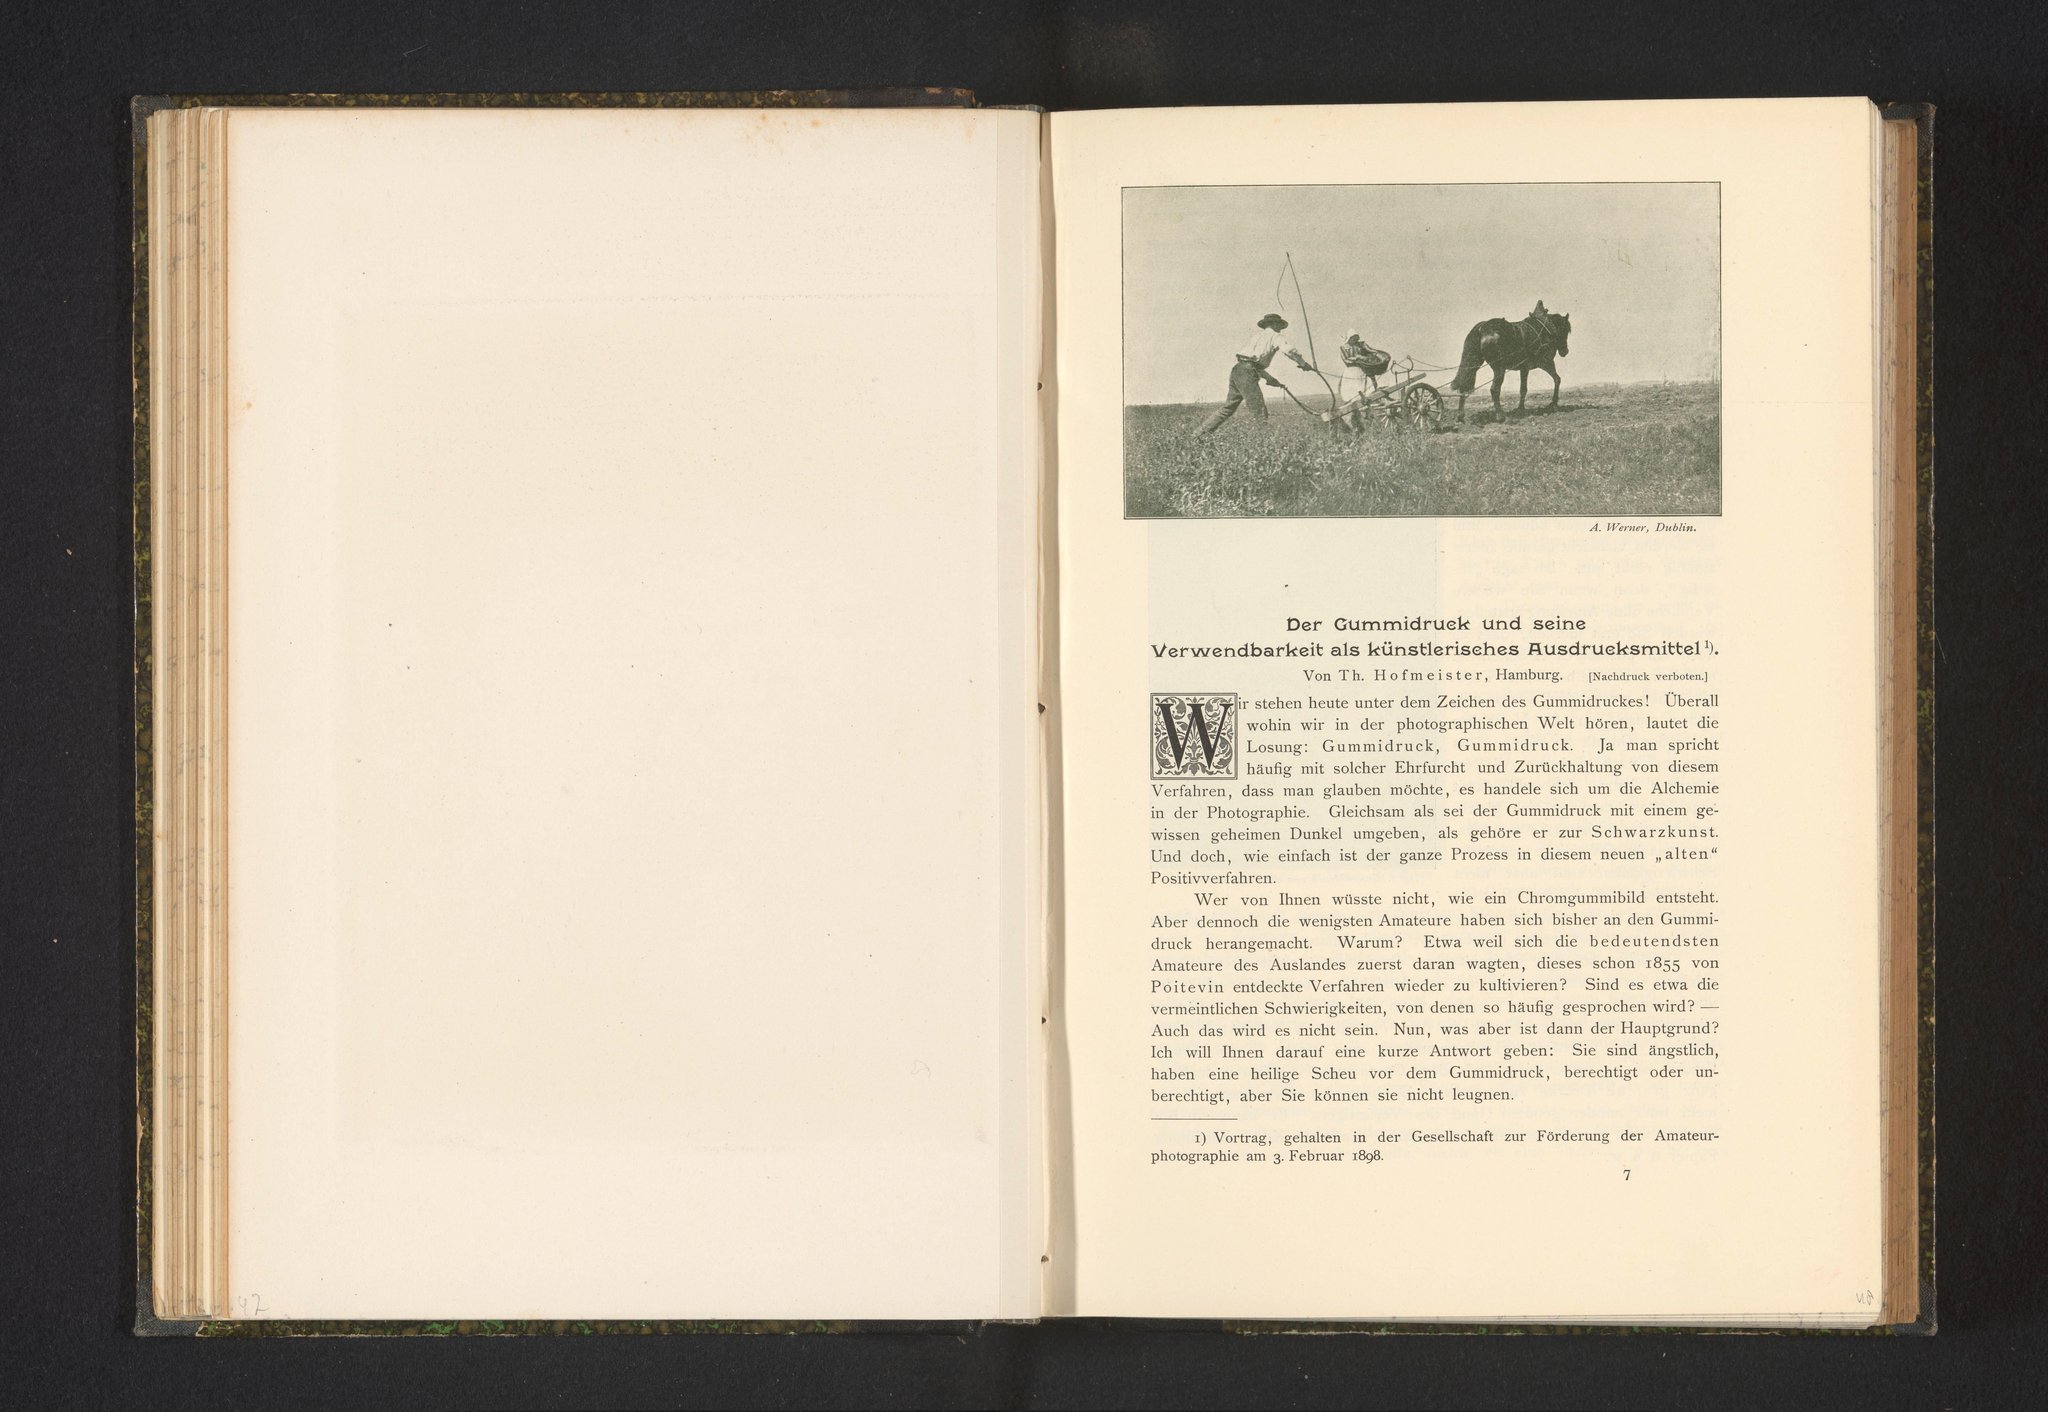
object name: photomechanical print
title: Boer met een paardenploeg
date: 1893-1898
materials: paper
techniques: photoaquatint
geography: dublin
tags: farmers, ploughing